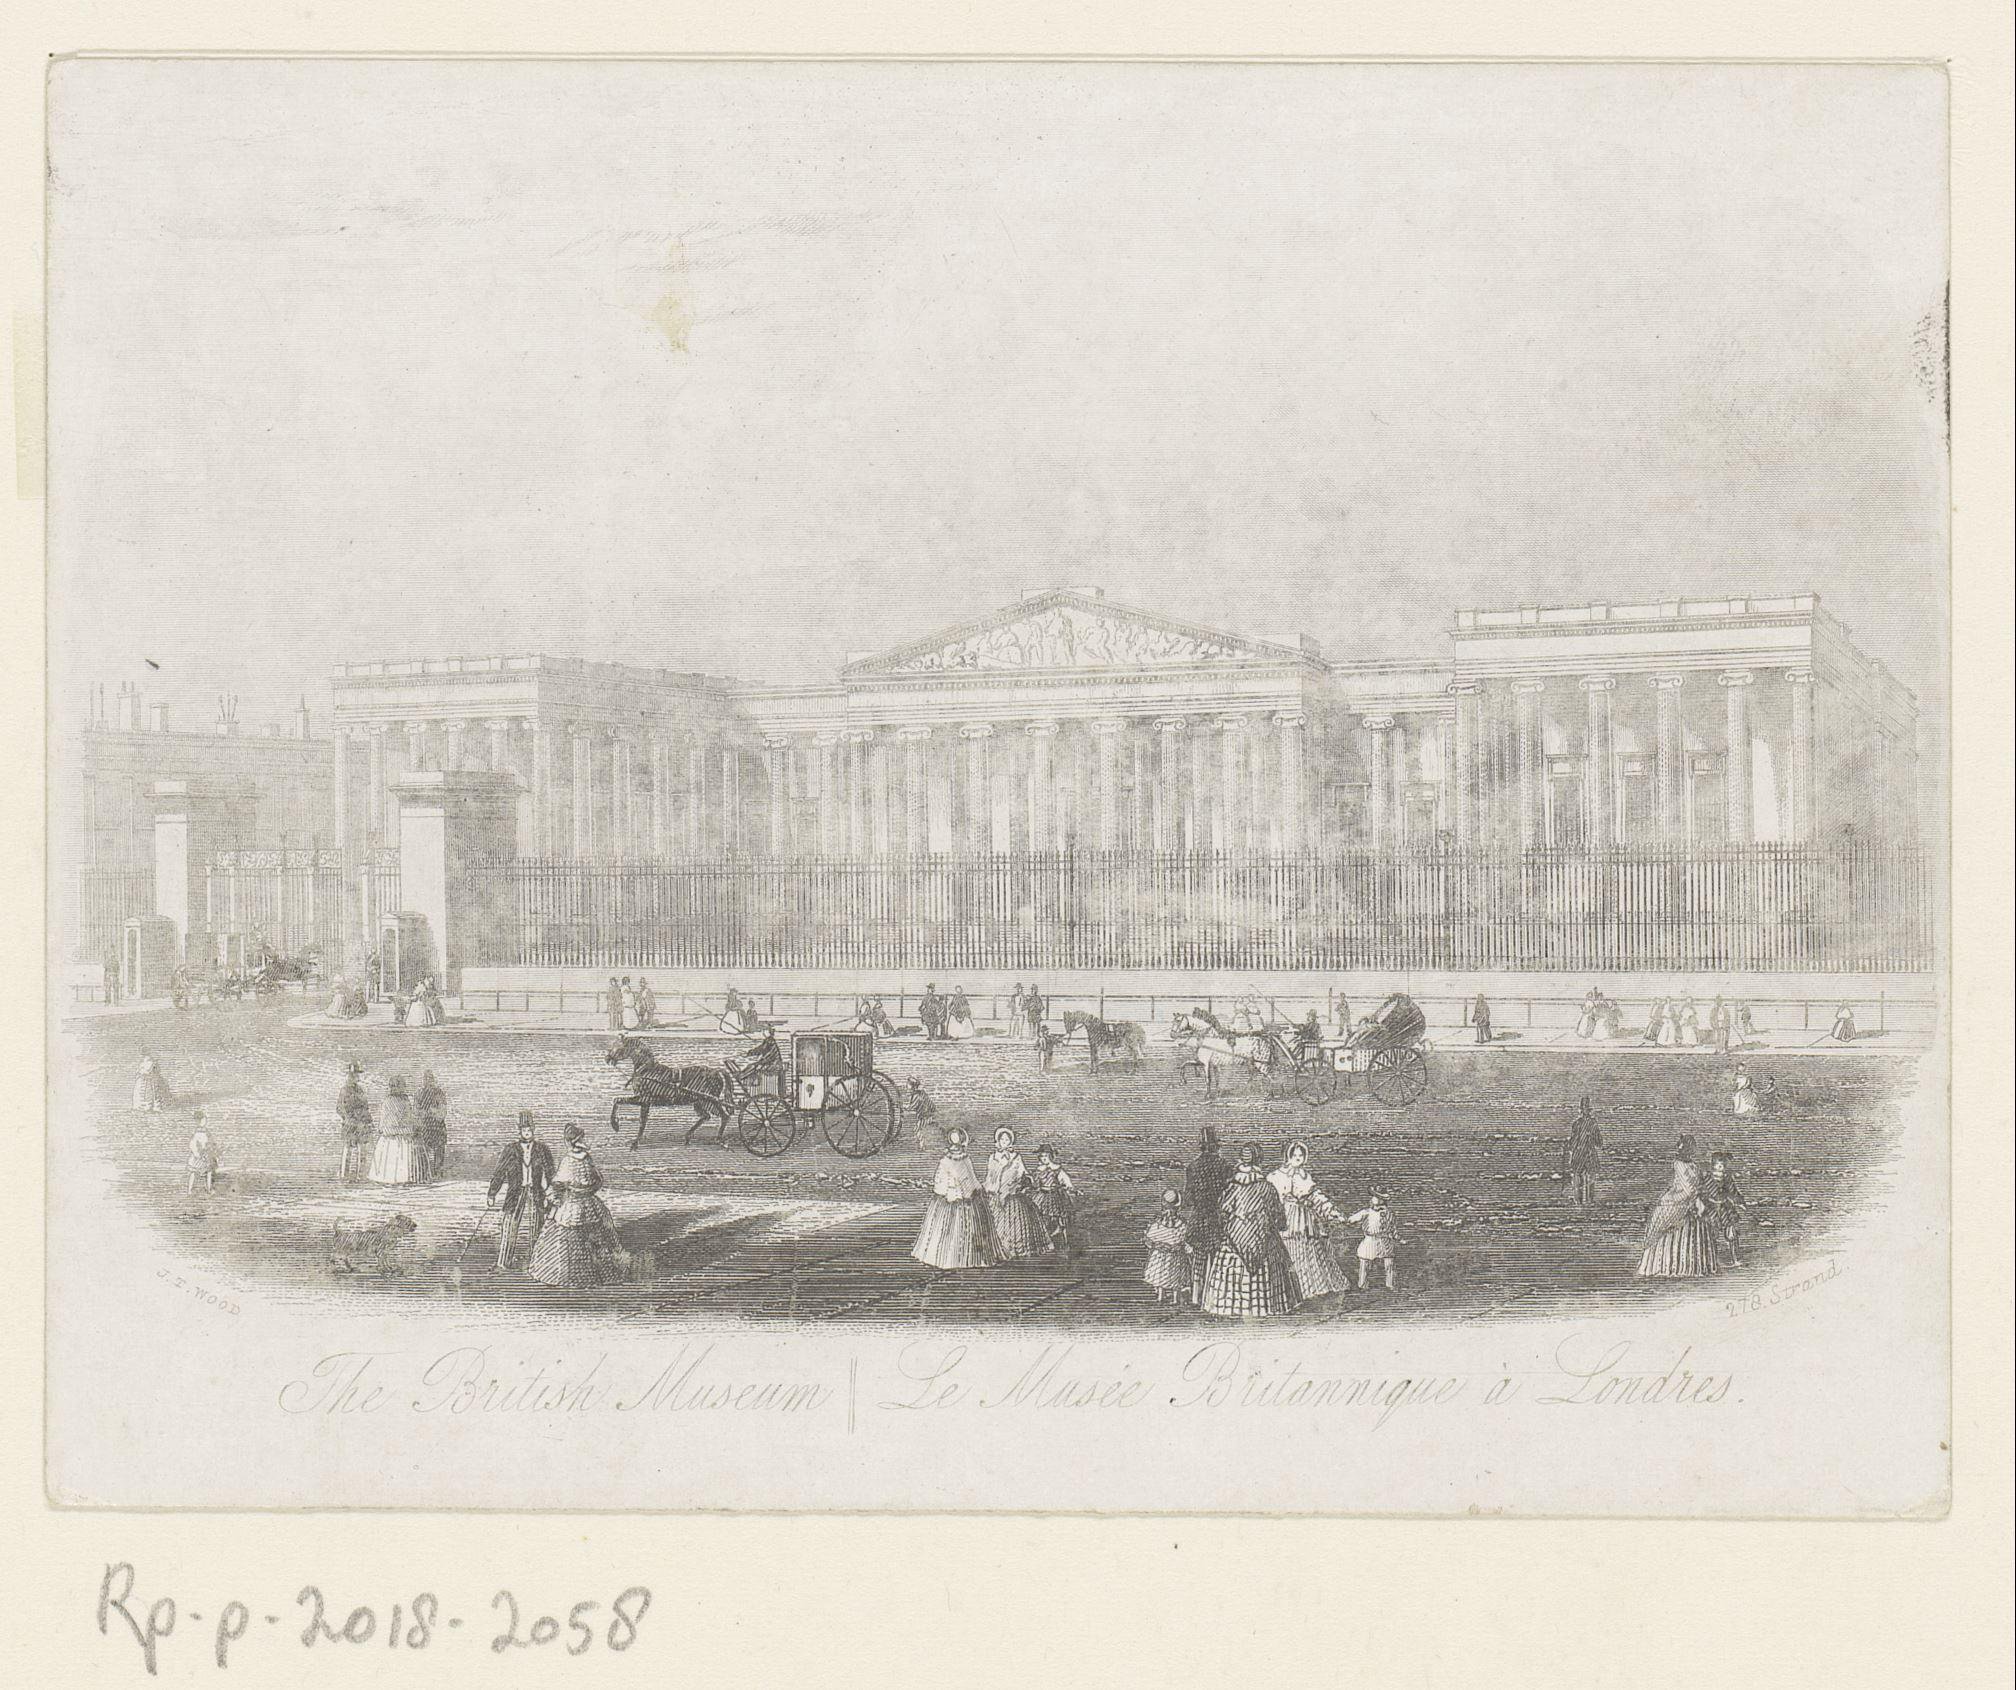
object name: print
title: Gezicht op het British Museum, te Londen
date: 1841-1885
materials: paper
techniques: etching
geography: london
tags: permanent exhibition, museum